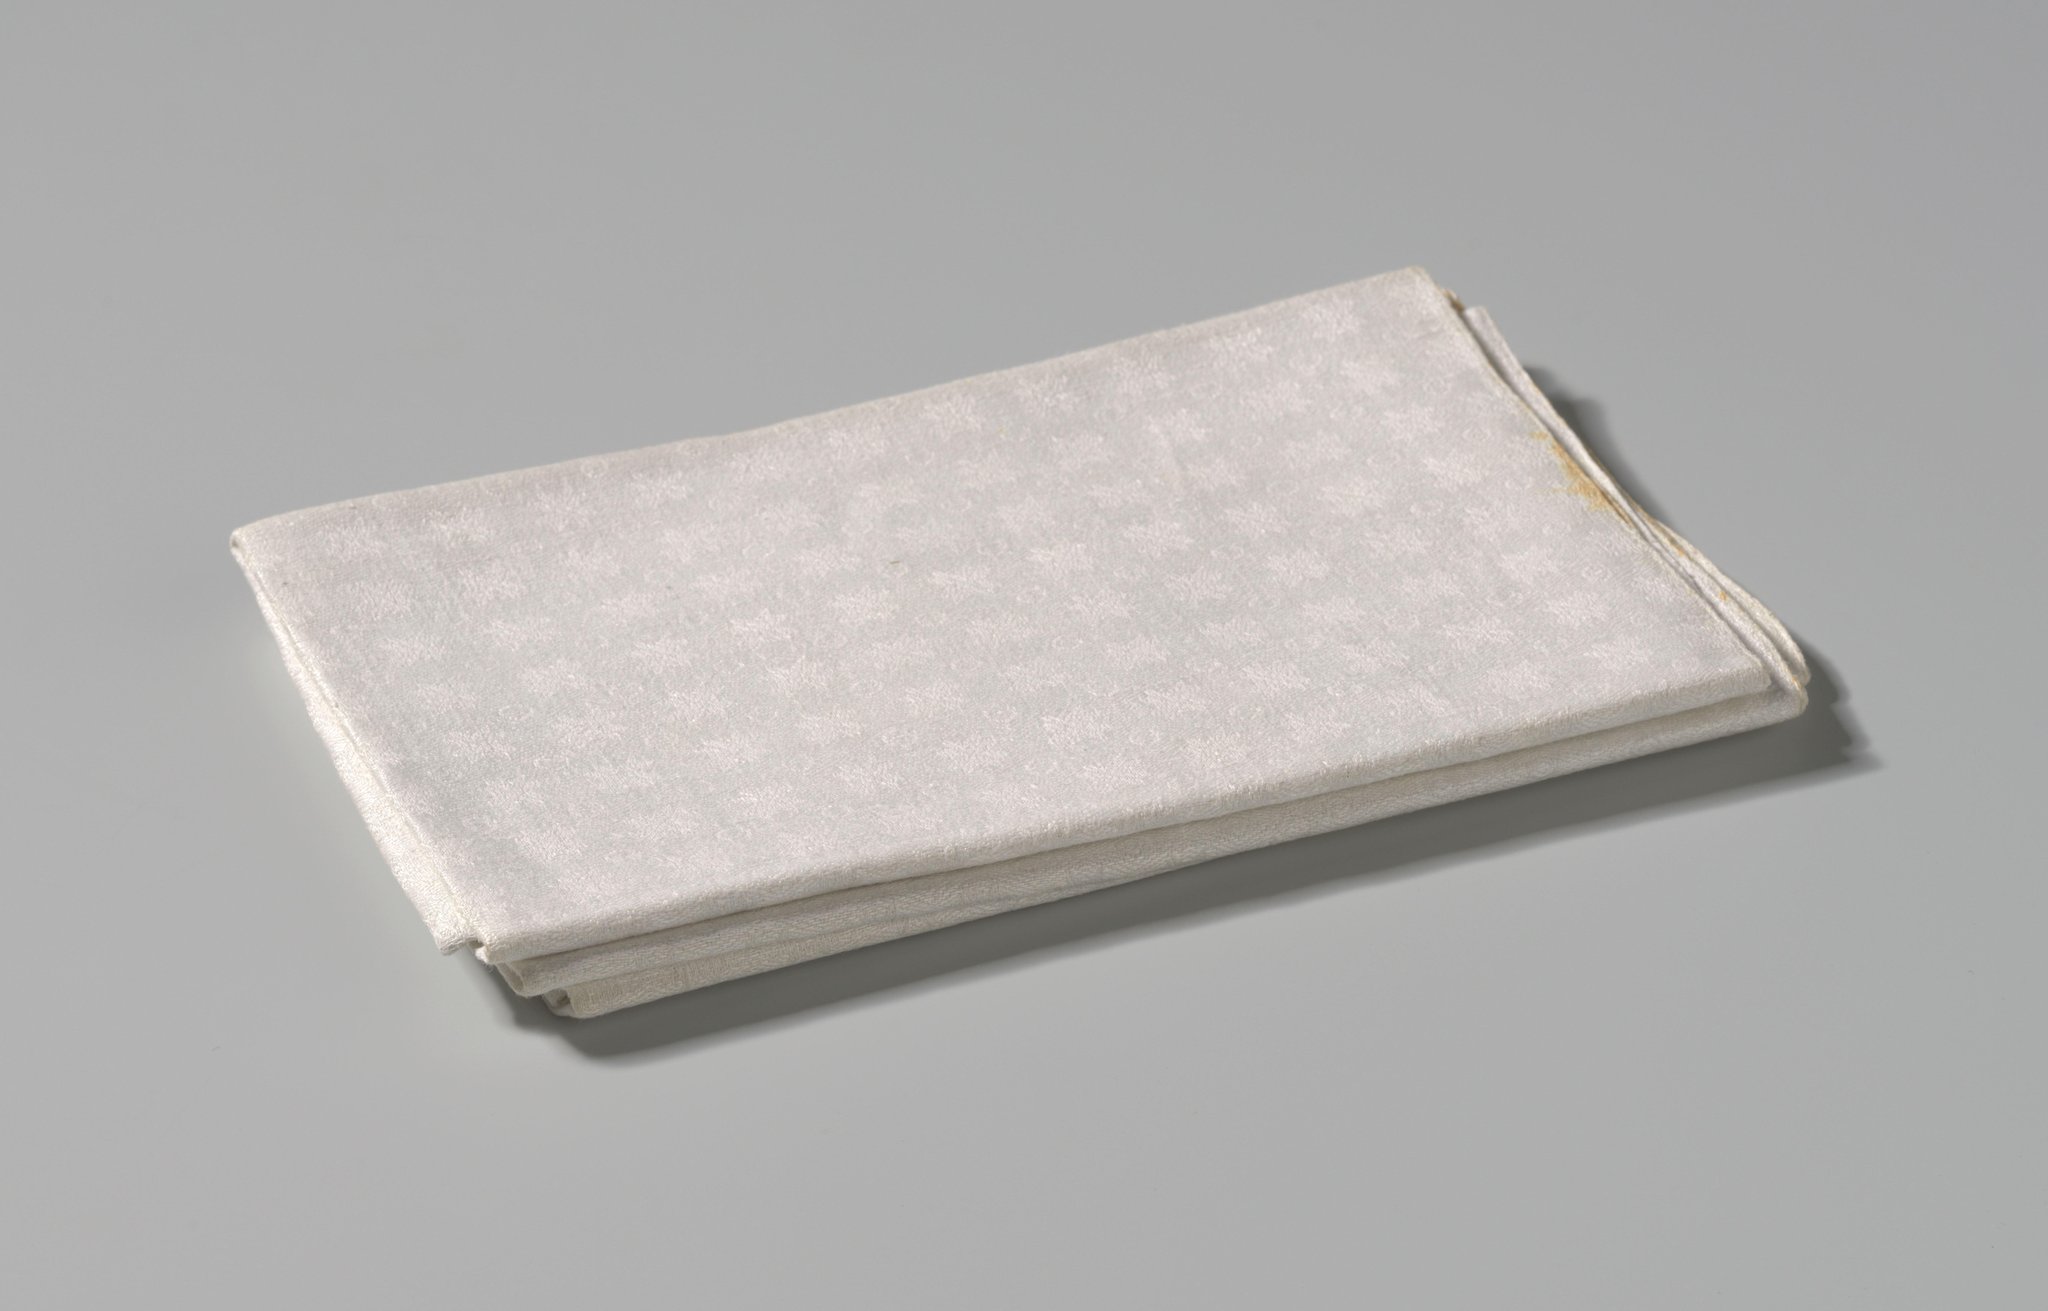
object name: towel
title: Handdoek van wit linnen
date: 1800-1875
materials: linen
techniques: damask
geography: northern netherlands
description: Wit linnendamasten handdoek met een patroon met een ster en rondje, merk RVD HW 36.